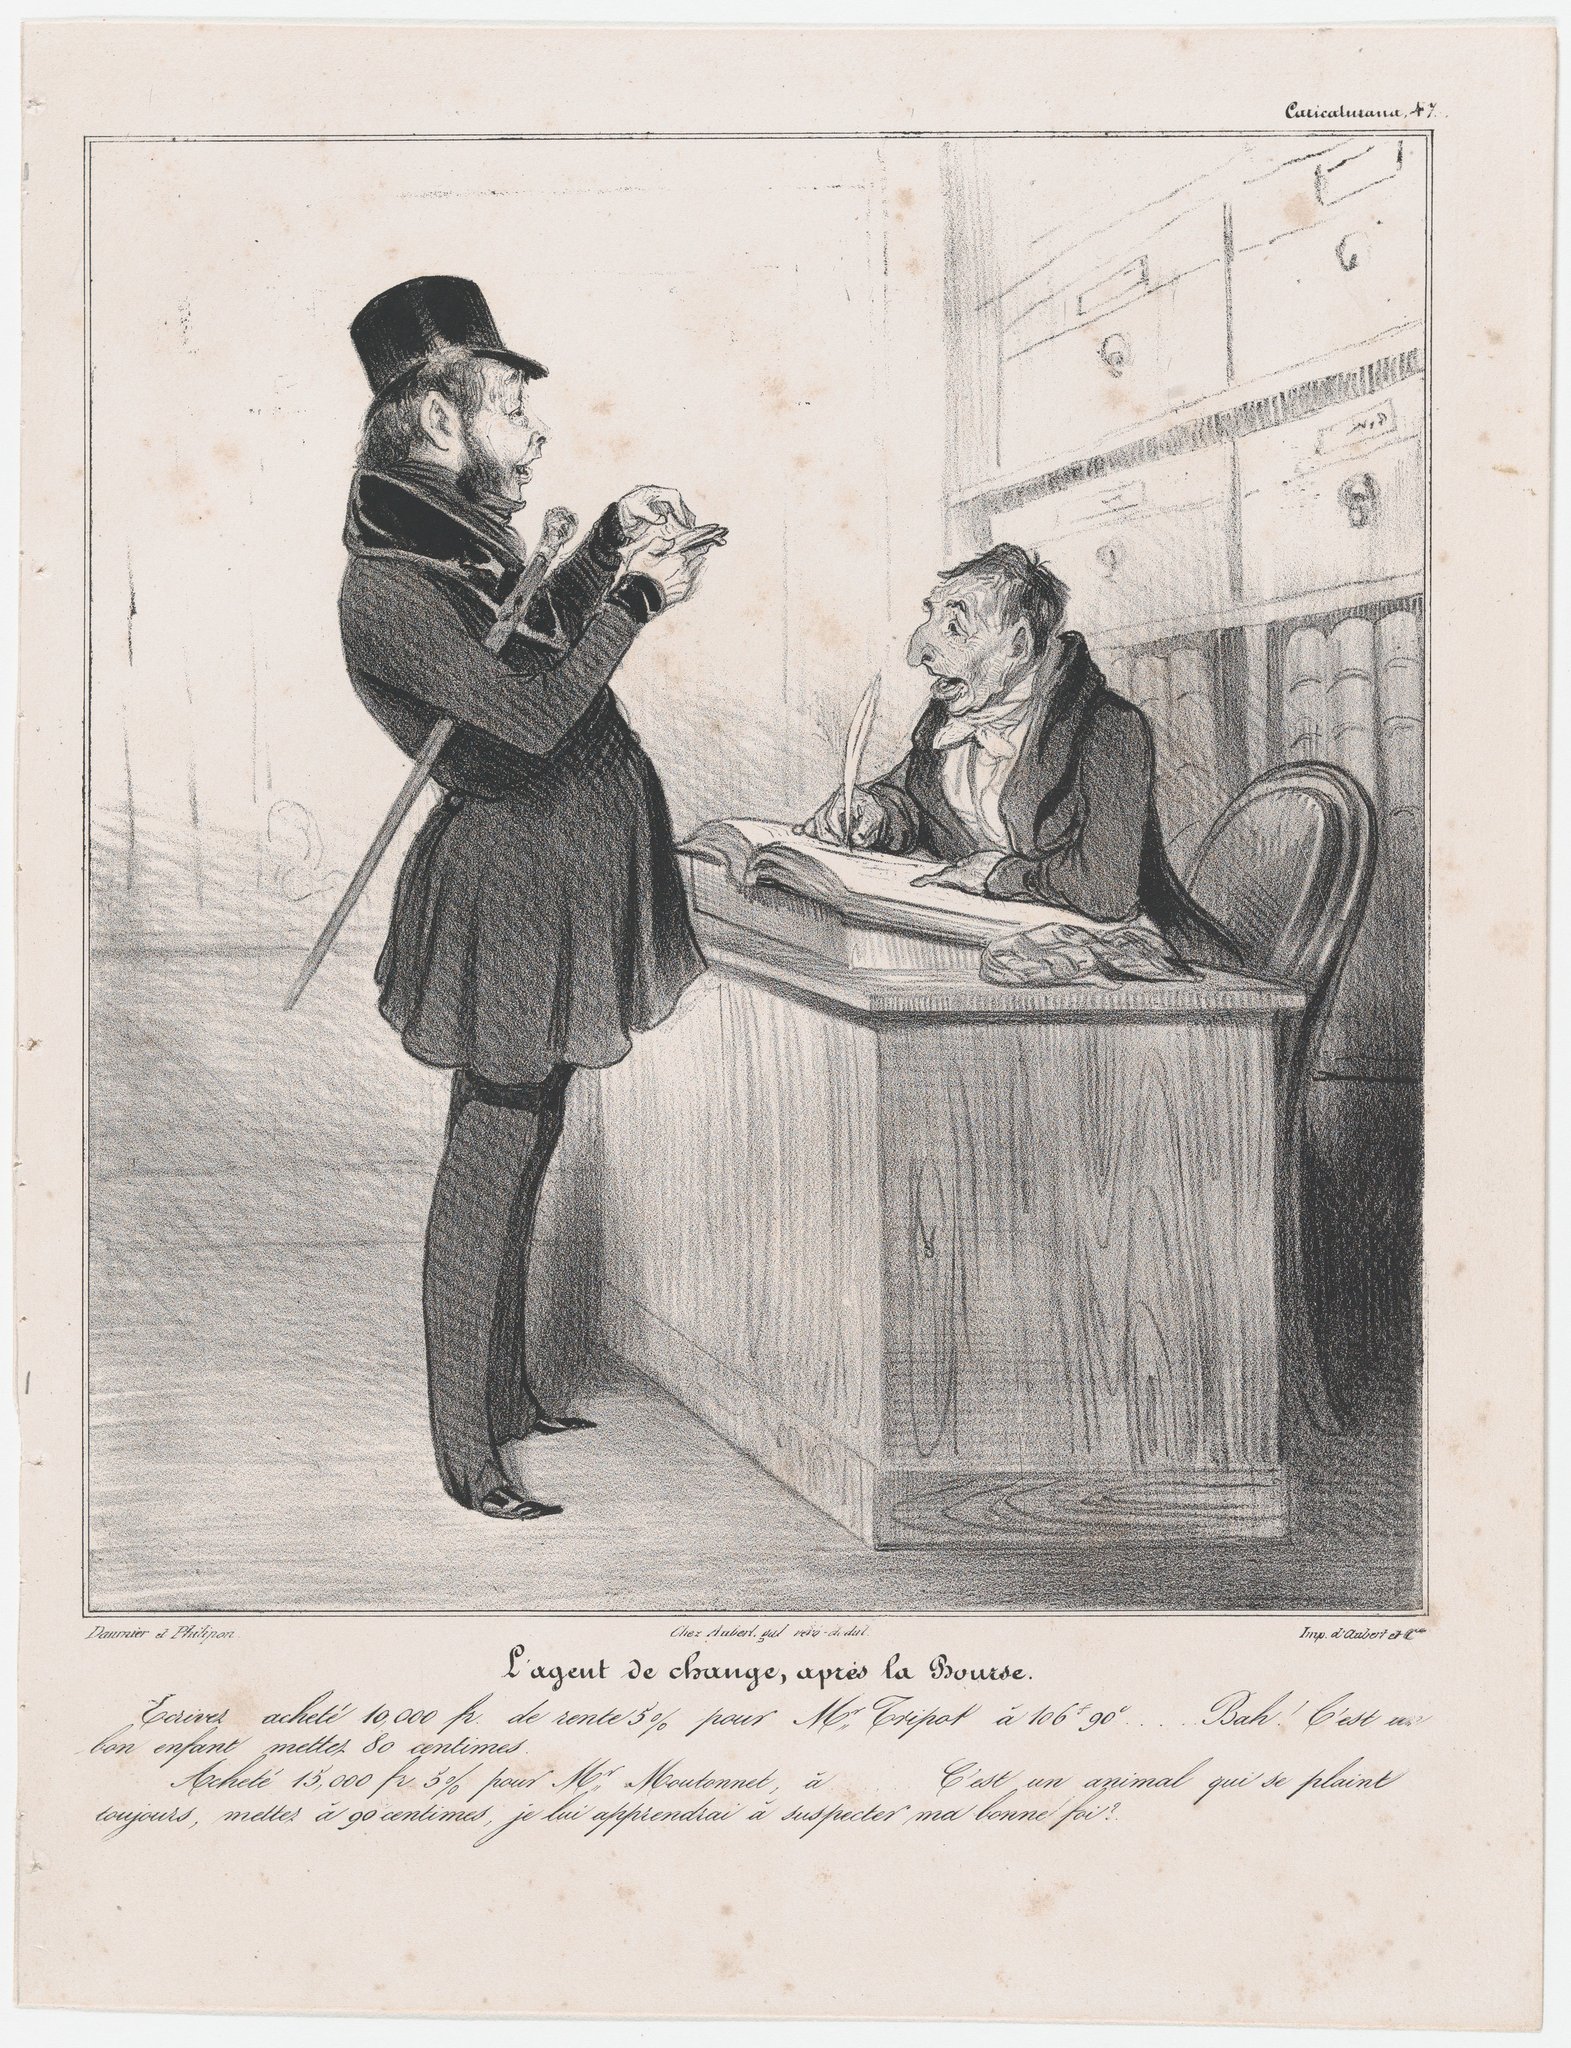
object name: print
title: Plate 47: Stockbroker at the close of the day, from 'Caricaturana,' published in Les Robert Macaires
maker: honoré daumier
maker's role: artist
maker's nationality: french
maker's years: 1808-1879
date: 1838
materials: paper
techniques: lithograph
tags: satire,men